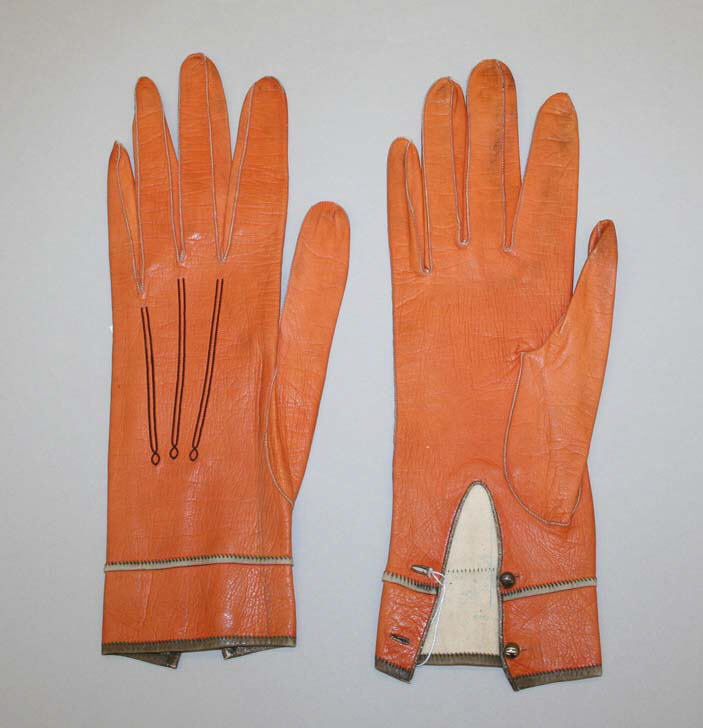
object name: glove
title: Gloves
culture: french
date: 1867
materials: leather